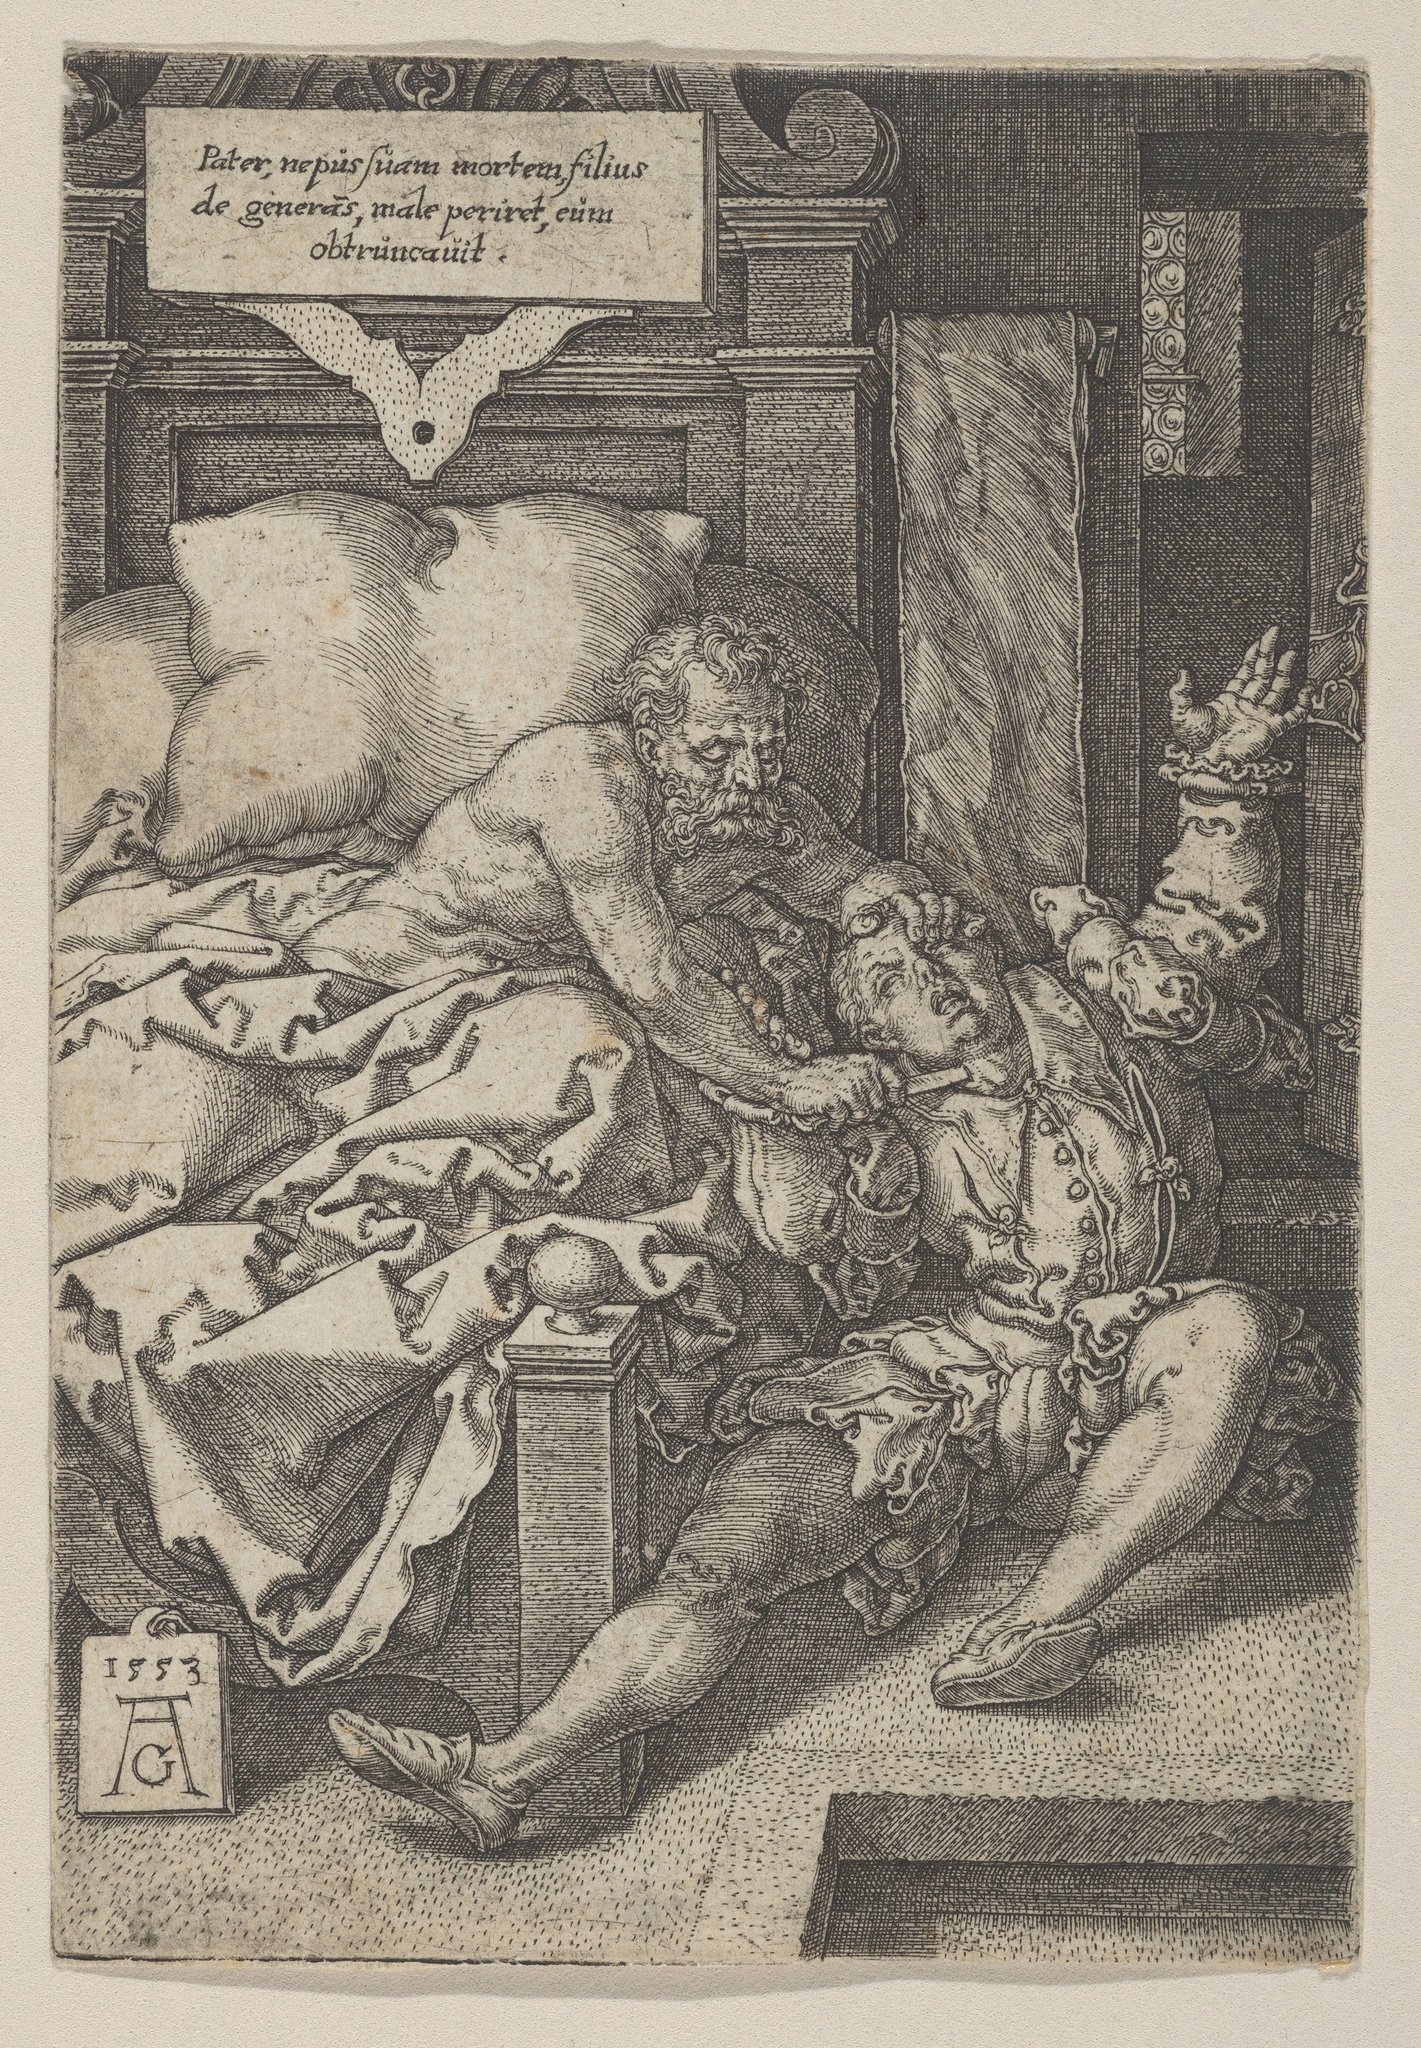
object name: print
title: Judge Herkinbald (Archambauld) Stabbing his Nephew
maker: heinrich aldegrever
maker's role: artist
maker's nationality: german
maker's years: 1502-1561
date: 1553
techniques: engraving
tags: bedrooms,suffering,men